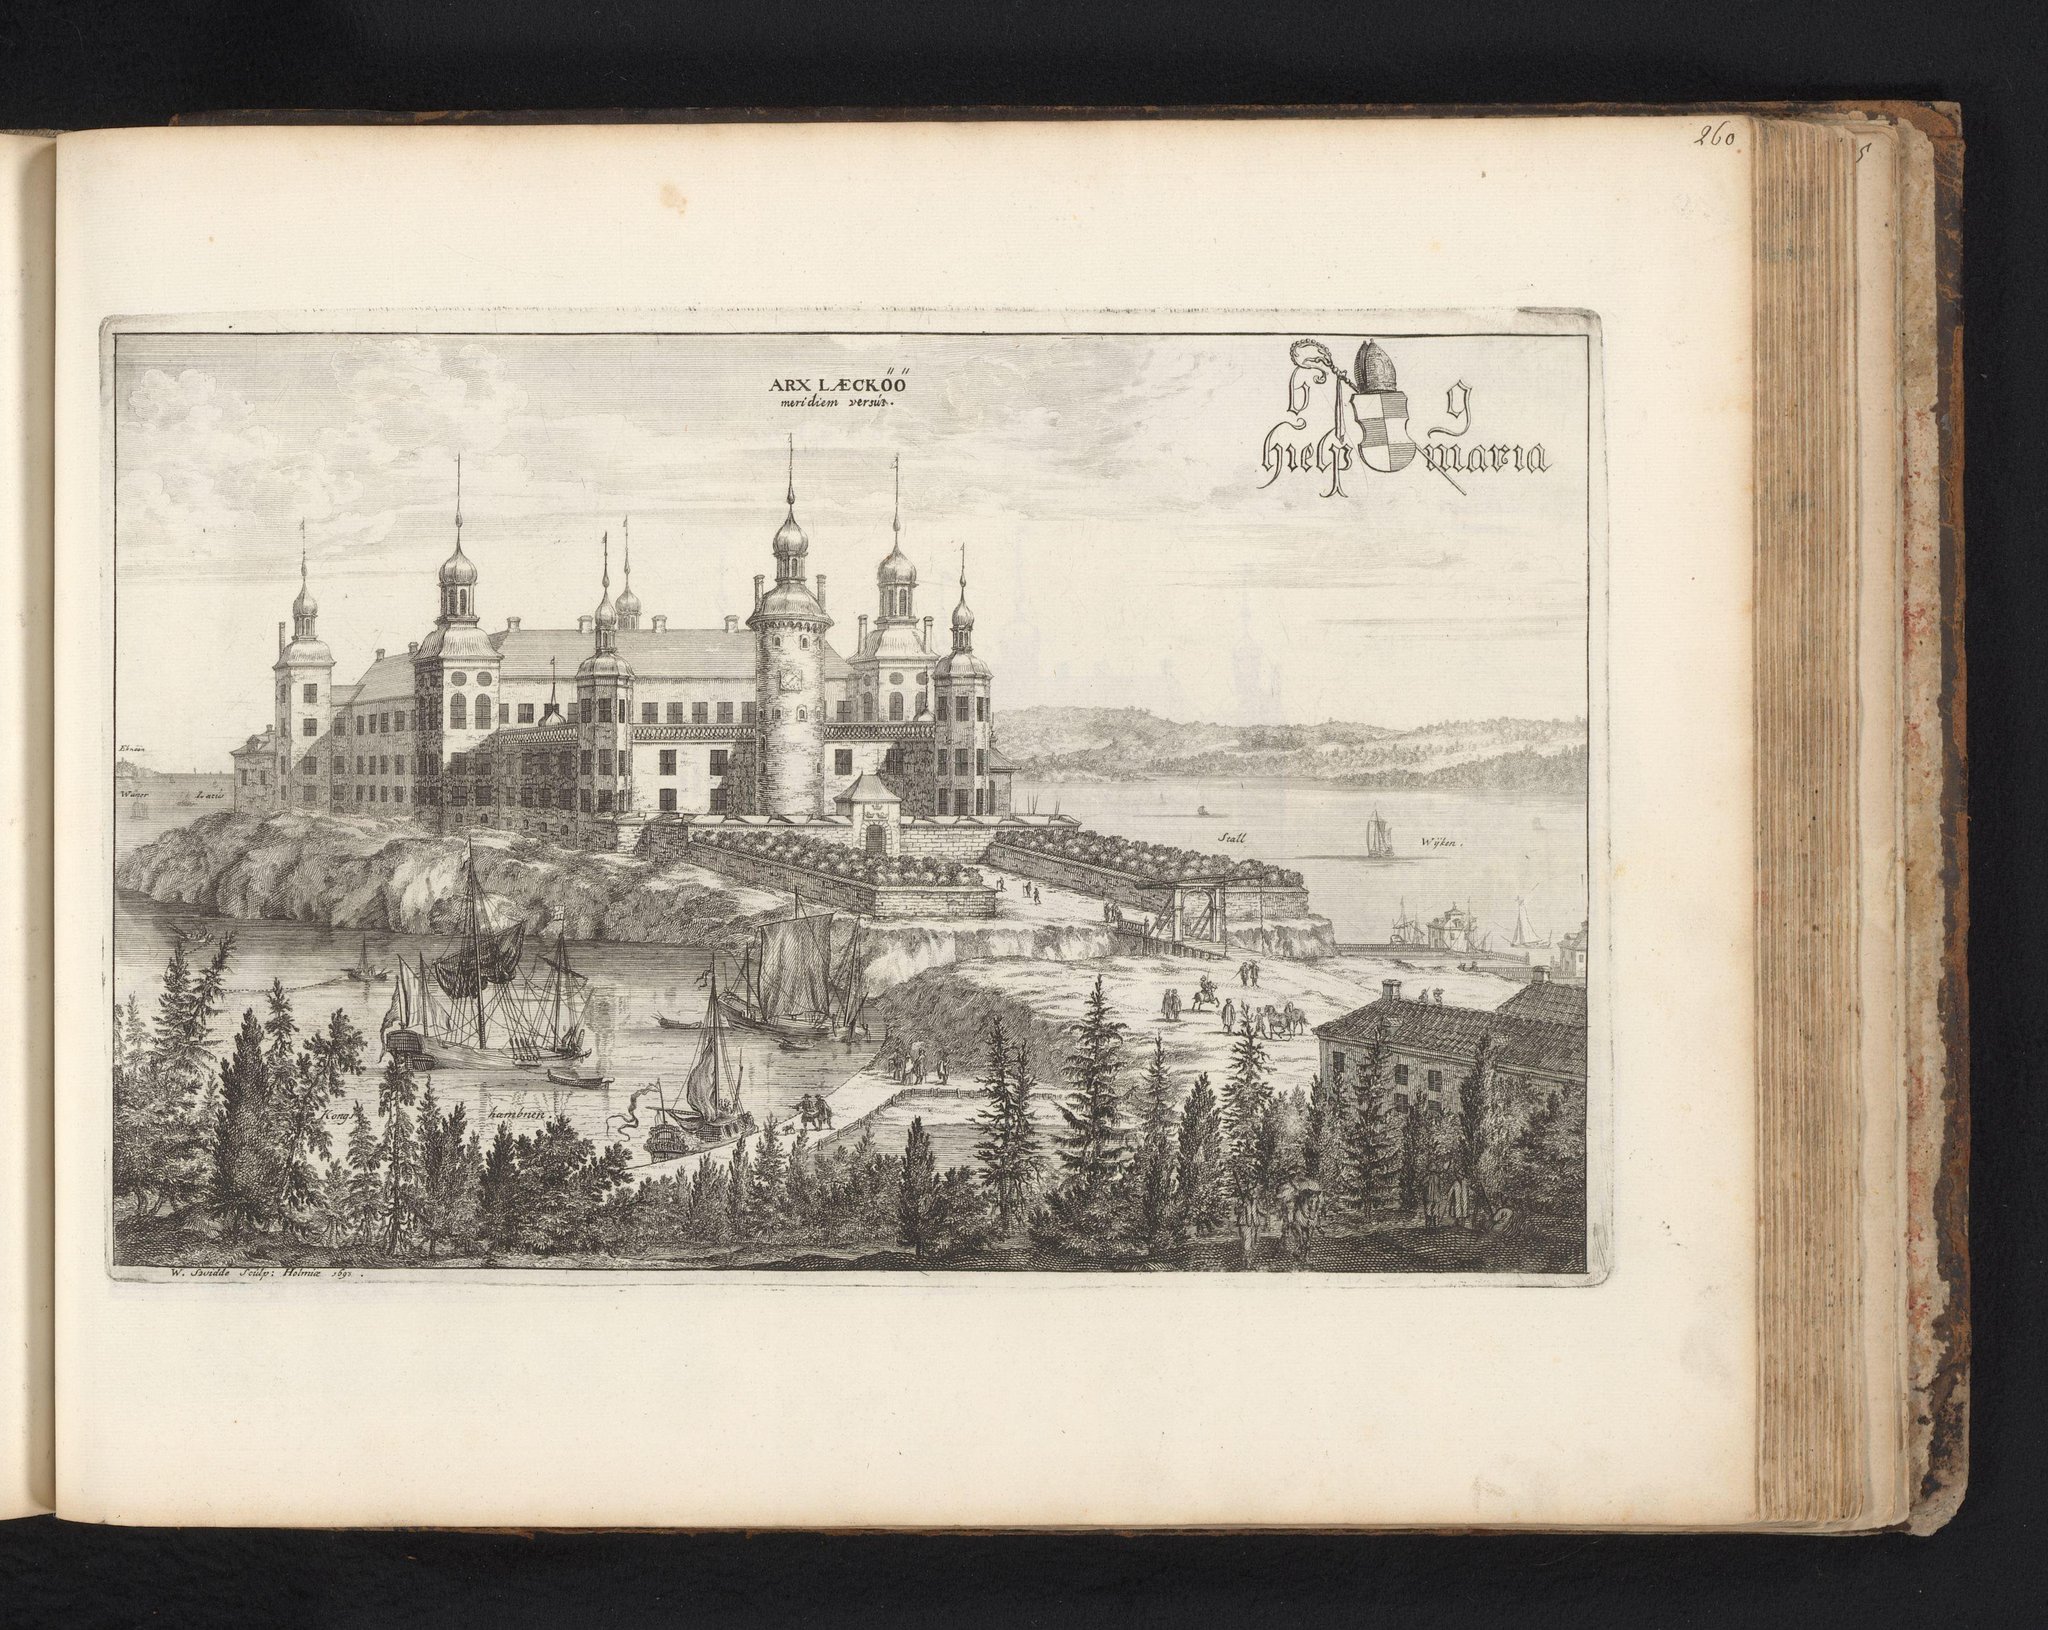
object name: print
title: Gezicht op slot Läckö, vanuit het zuiden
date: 1693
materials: paper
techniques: etching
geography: stockholm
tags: castle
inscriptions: date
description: Kungliga Biblioteket, 'Suecia': http://www.kb.se/samlingarna/Kartor-bilder/Suecia-antiqua/ (geraadpleegd november 2016).